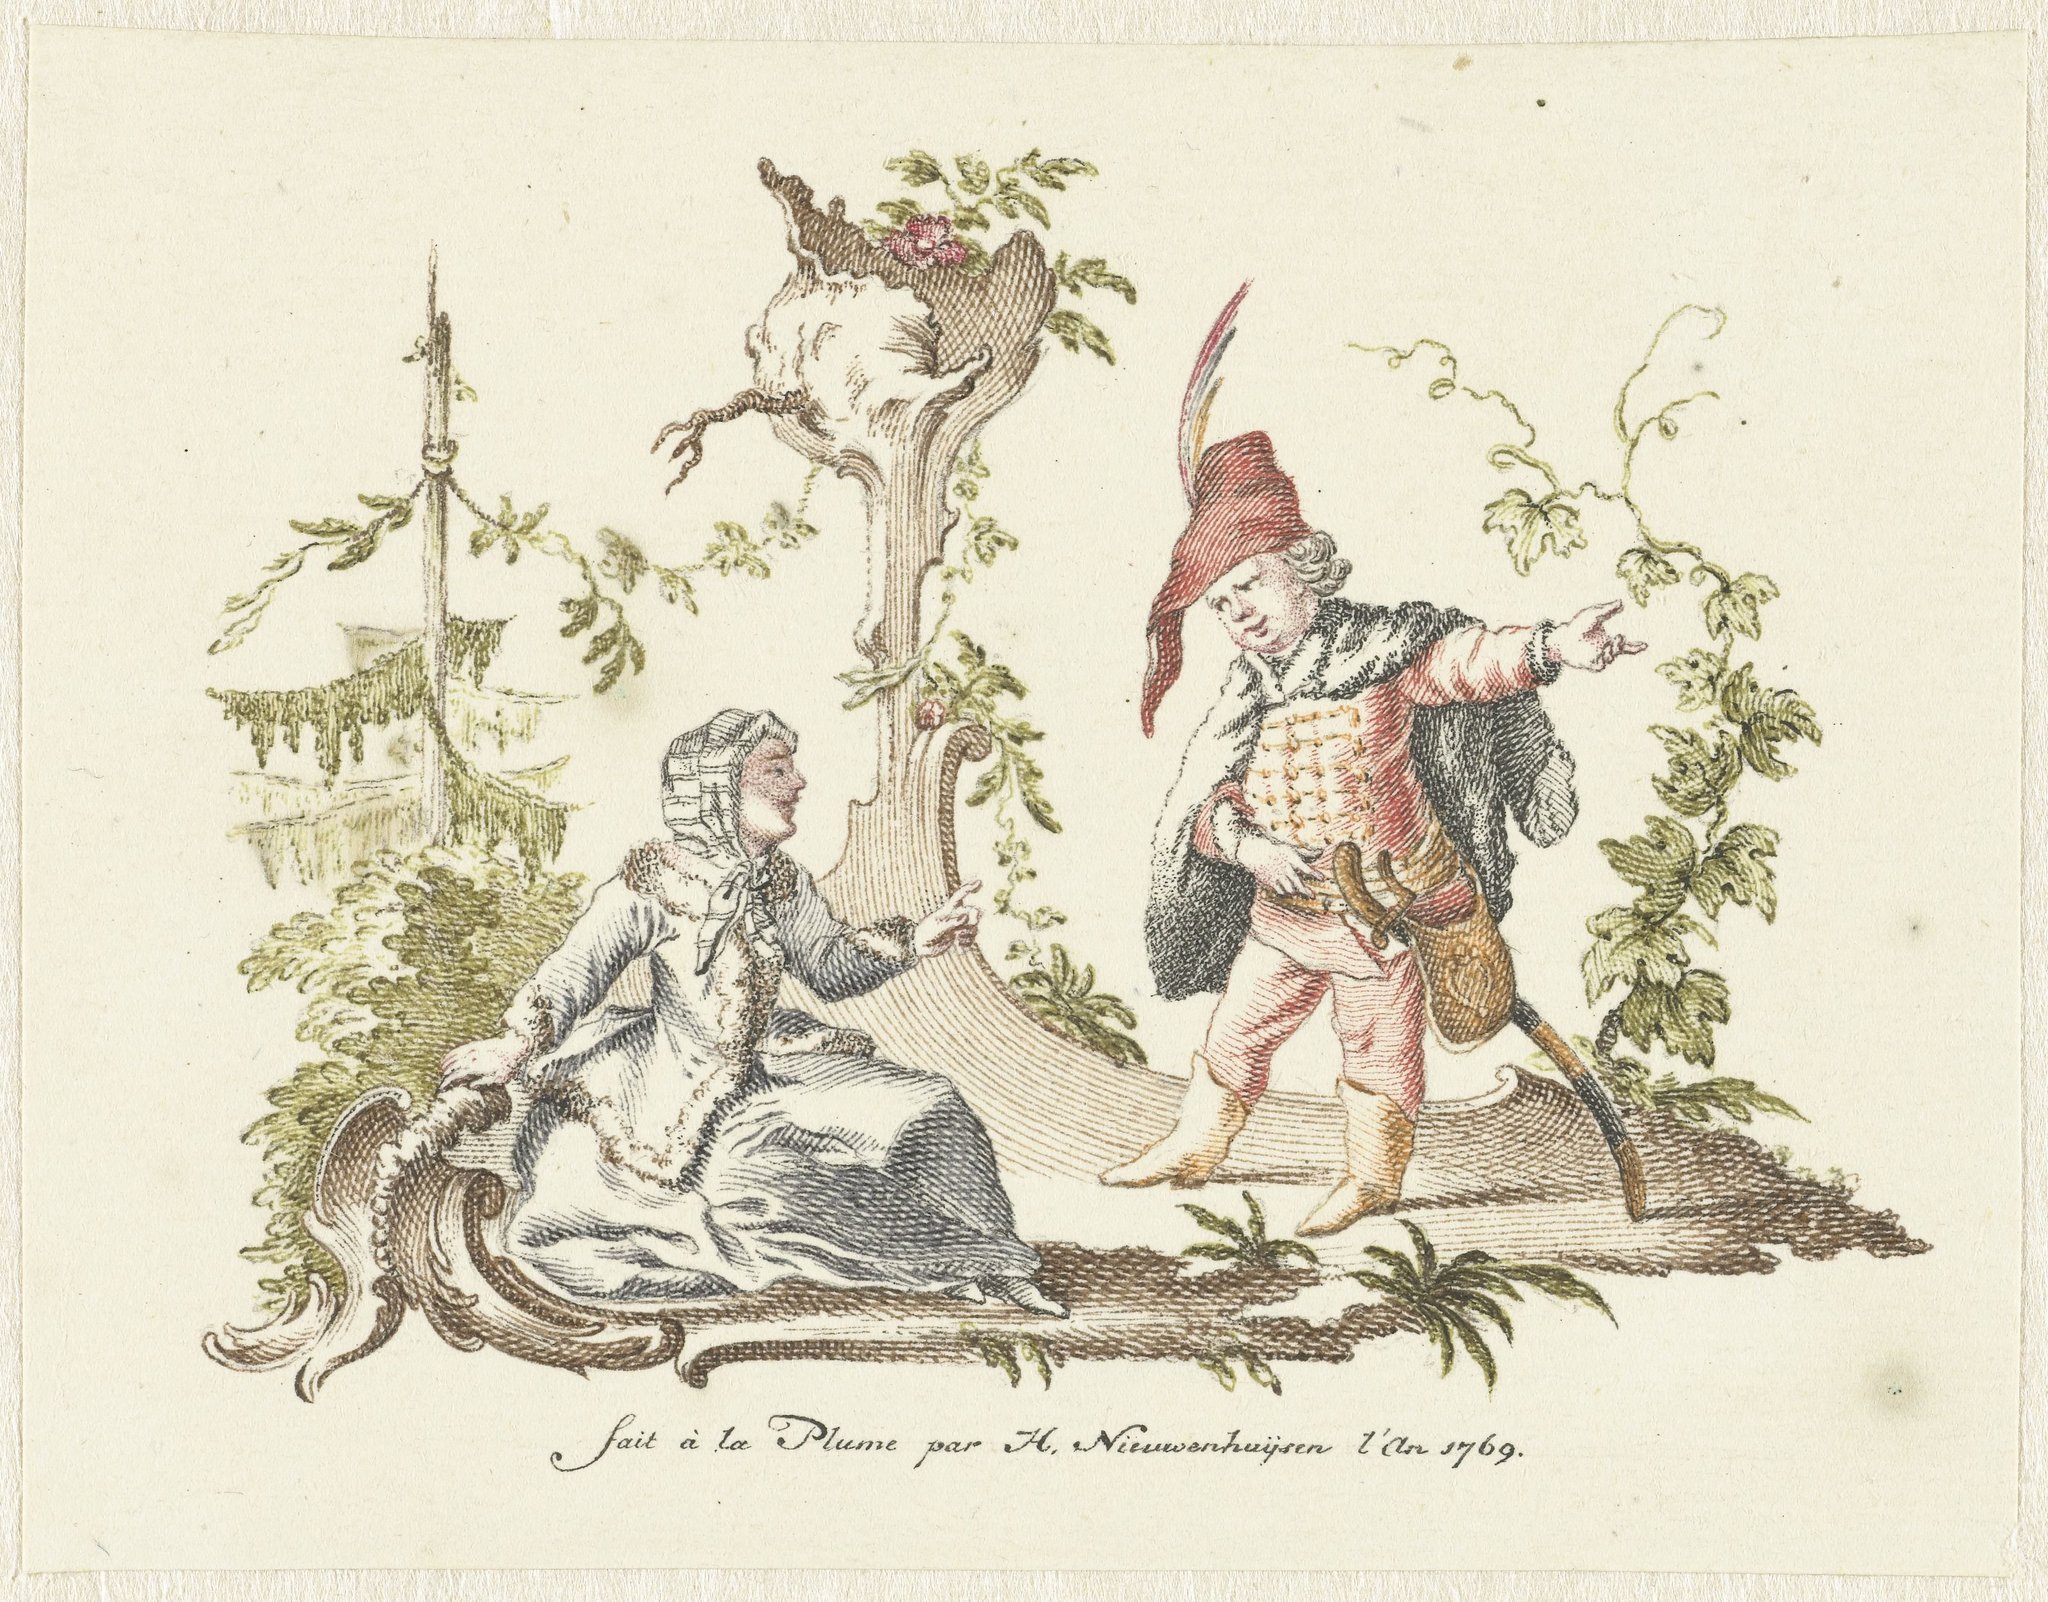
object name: drawing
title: Ornament met staand mannetje bij zittende vrouw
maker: hendrik nieuwenhuysen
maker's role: draughtsman, print maker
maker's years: 1747-1794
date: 1769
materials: ink, paper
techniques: pen